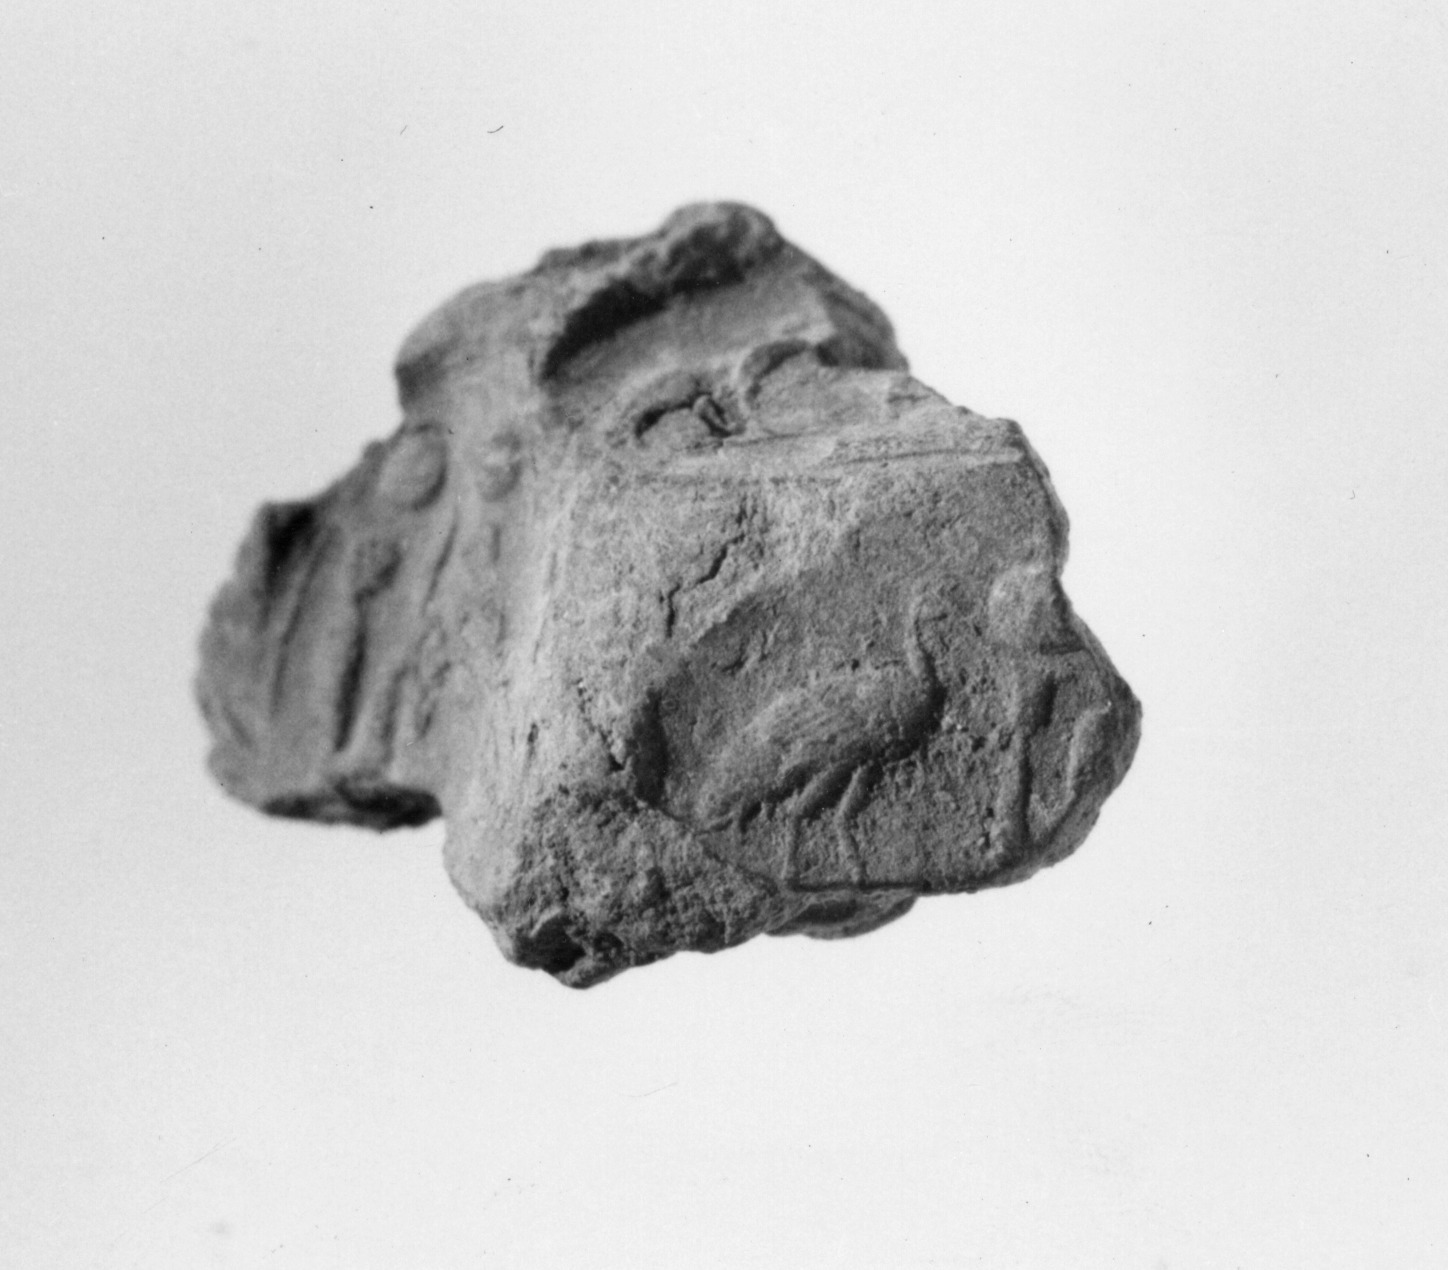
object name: sealing, amenhotep iii, nebmaatre, horus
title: Document Sealing With Multiple Seal Impressions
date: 1390-1352 BCE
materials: mud